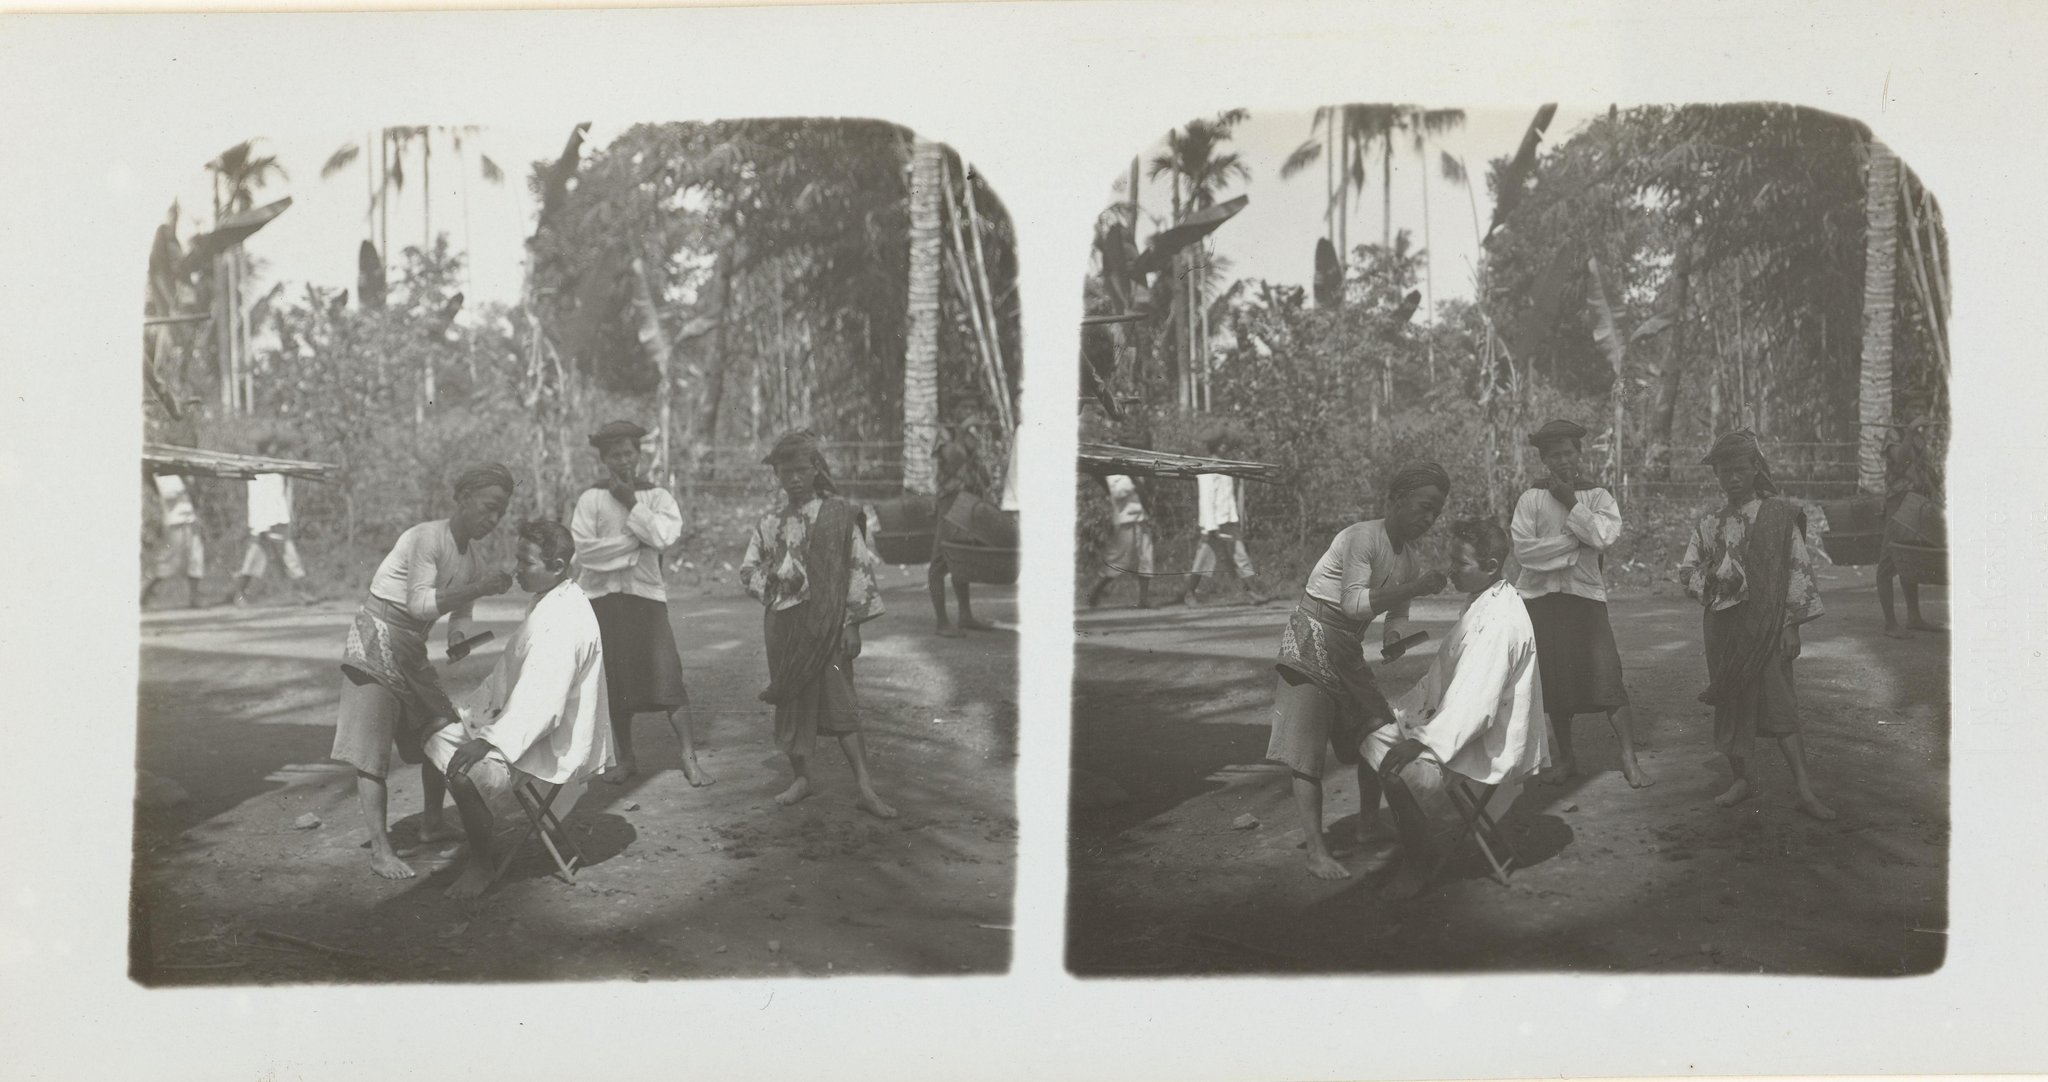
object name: stereograph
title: S 9 No 105. Een straatbarbier.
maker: neville keasberry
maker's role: fotograaf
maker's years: 1866-1944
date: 1900-1935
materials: cardboard, paper, photographic support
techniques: albumen print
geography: malang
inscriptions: signature: ‘Neville Keasberry, Malang (Java)’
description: Een straatbarbier knipt en scheert iemad in de buitenlucht, op de achtergrond twee toeschouwers.